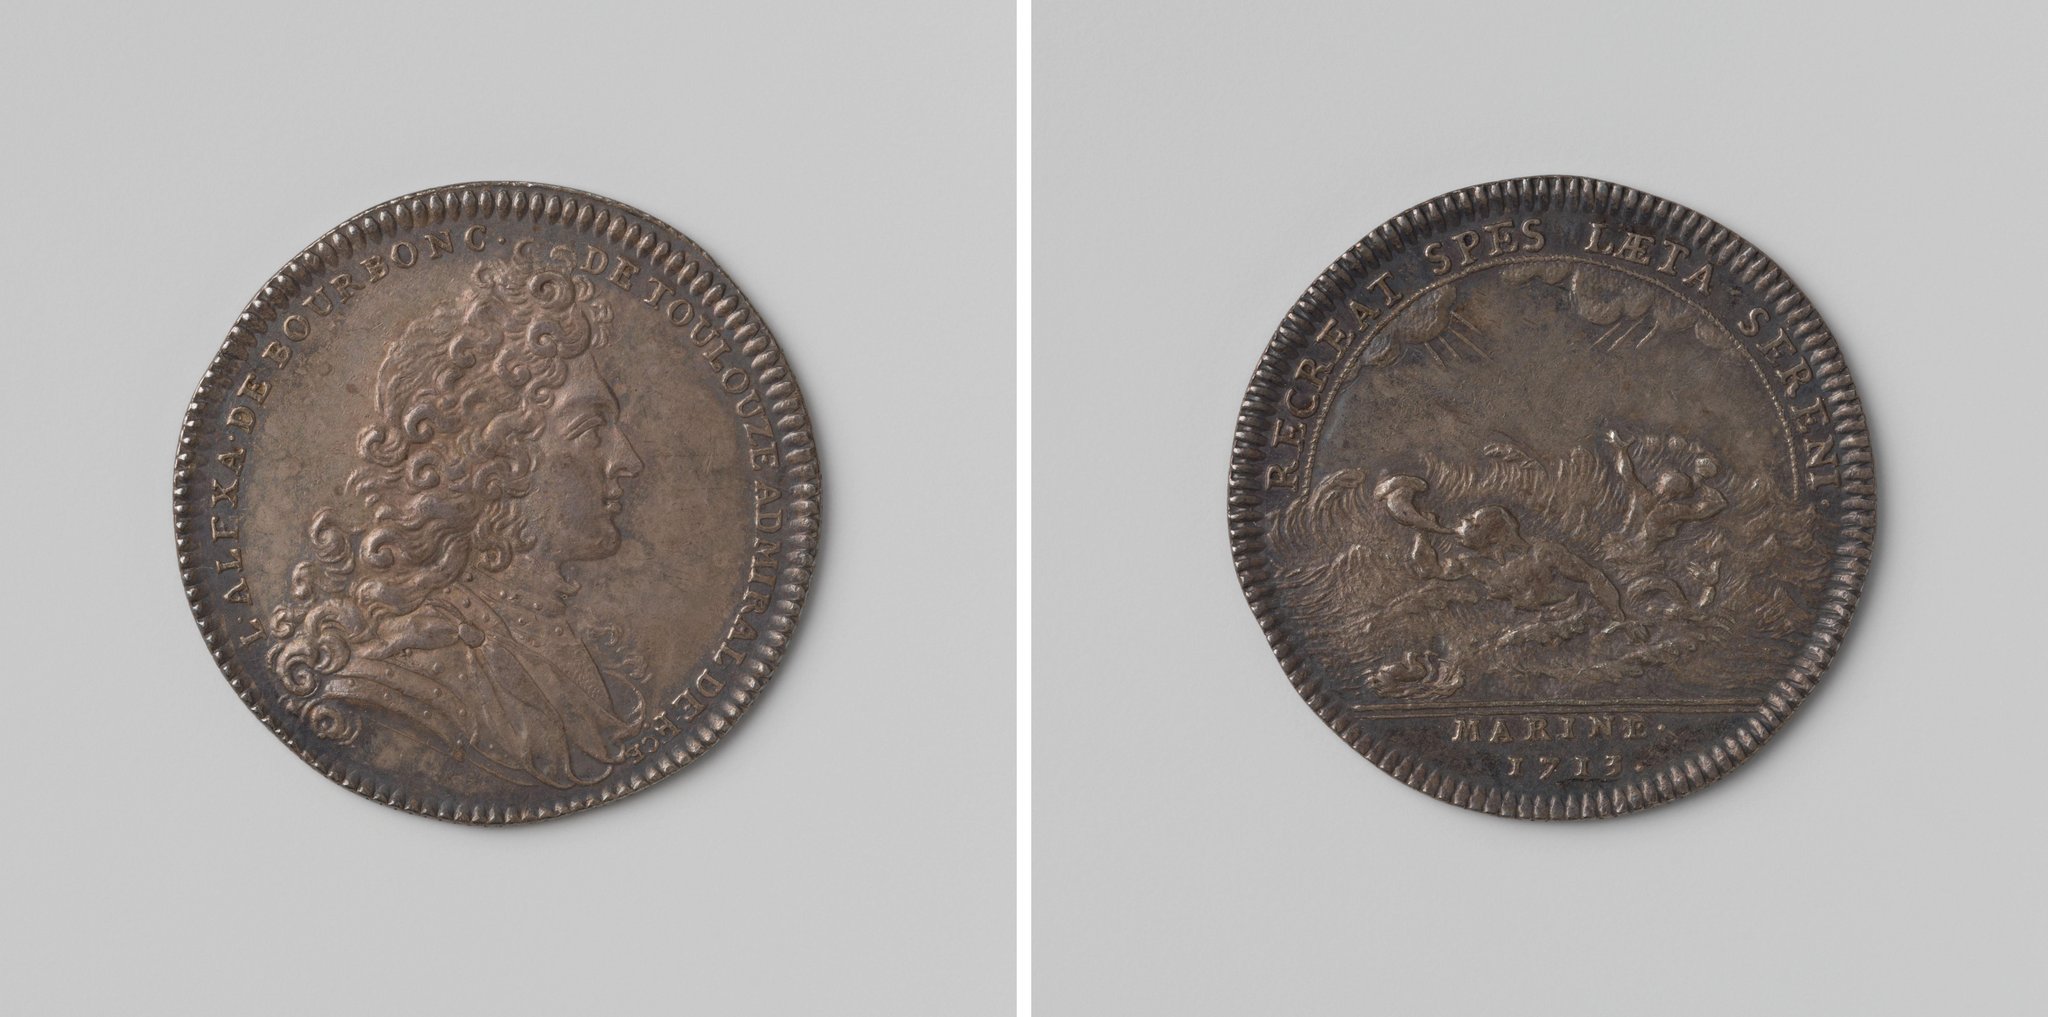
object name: jeton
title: Hoop op een spoedige vrede, rekenpenning geslagen ter ere van Lodewijk Alexander, graaf van Toulouse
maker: Anonymous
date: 1713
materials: silver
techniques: striking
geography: france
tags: louis alexandre (count of toulouse)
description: Zilveren penning. Voorzijde: borststuk man binnen omschrift. Keerzijde: tritons, die door op bazuinen te blazen, woelige zee pogen te kalmeren binnen omschrift; afsnede: opschrift